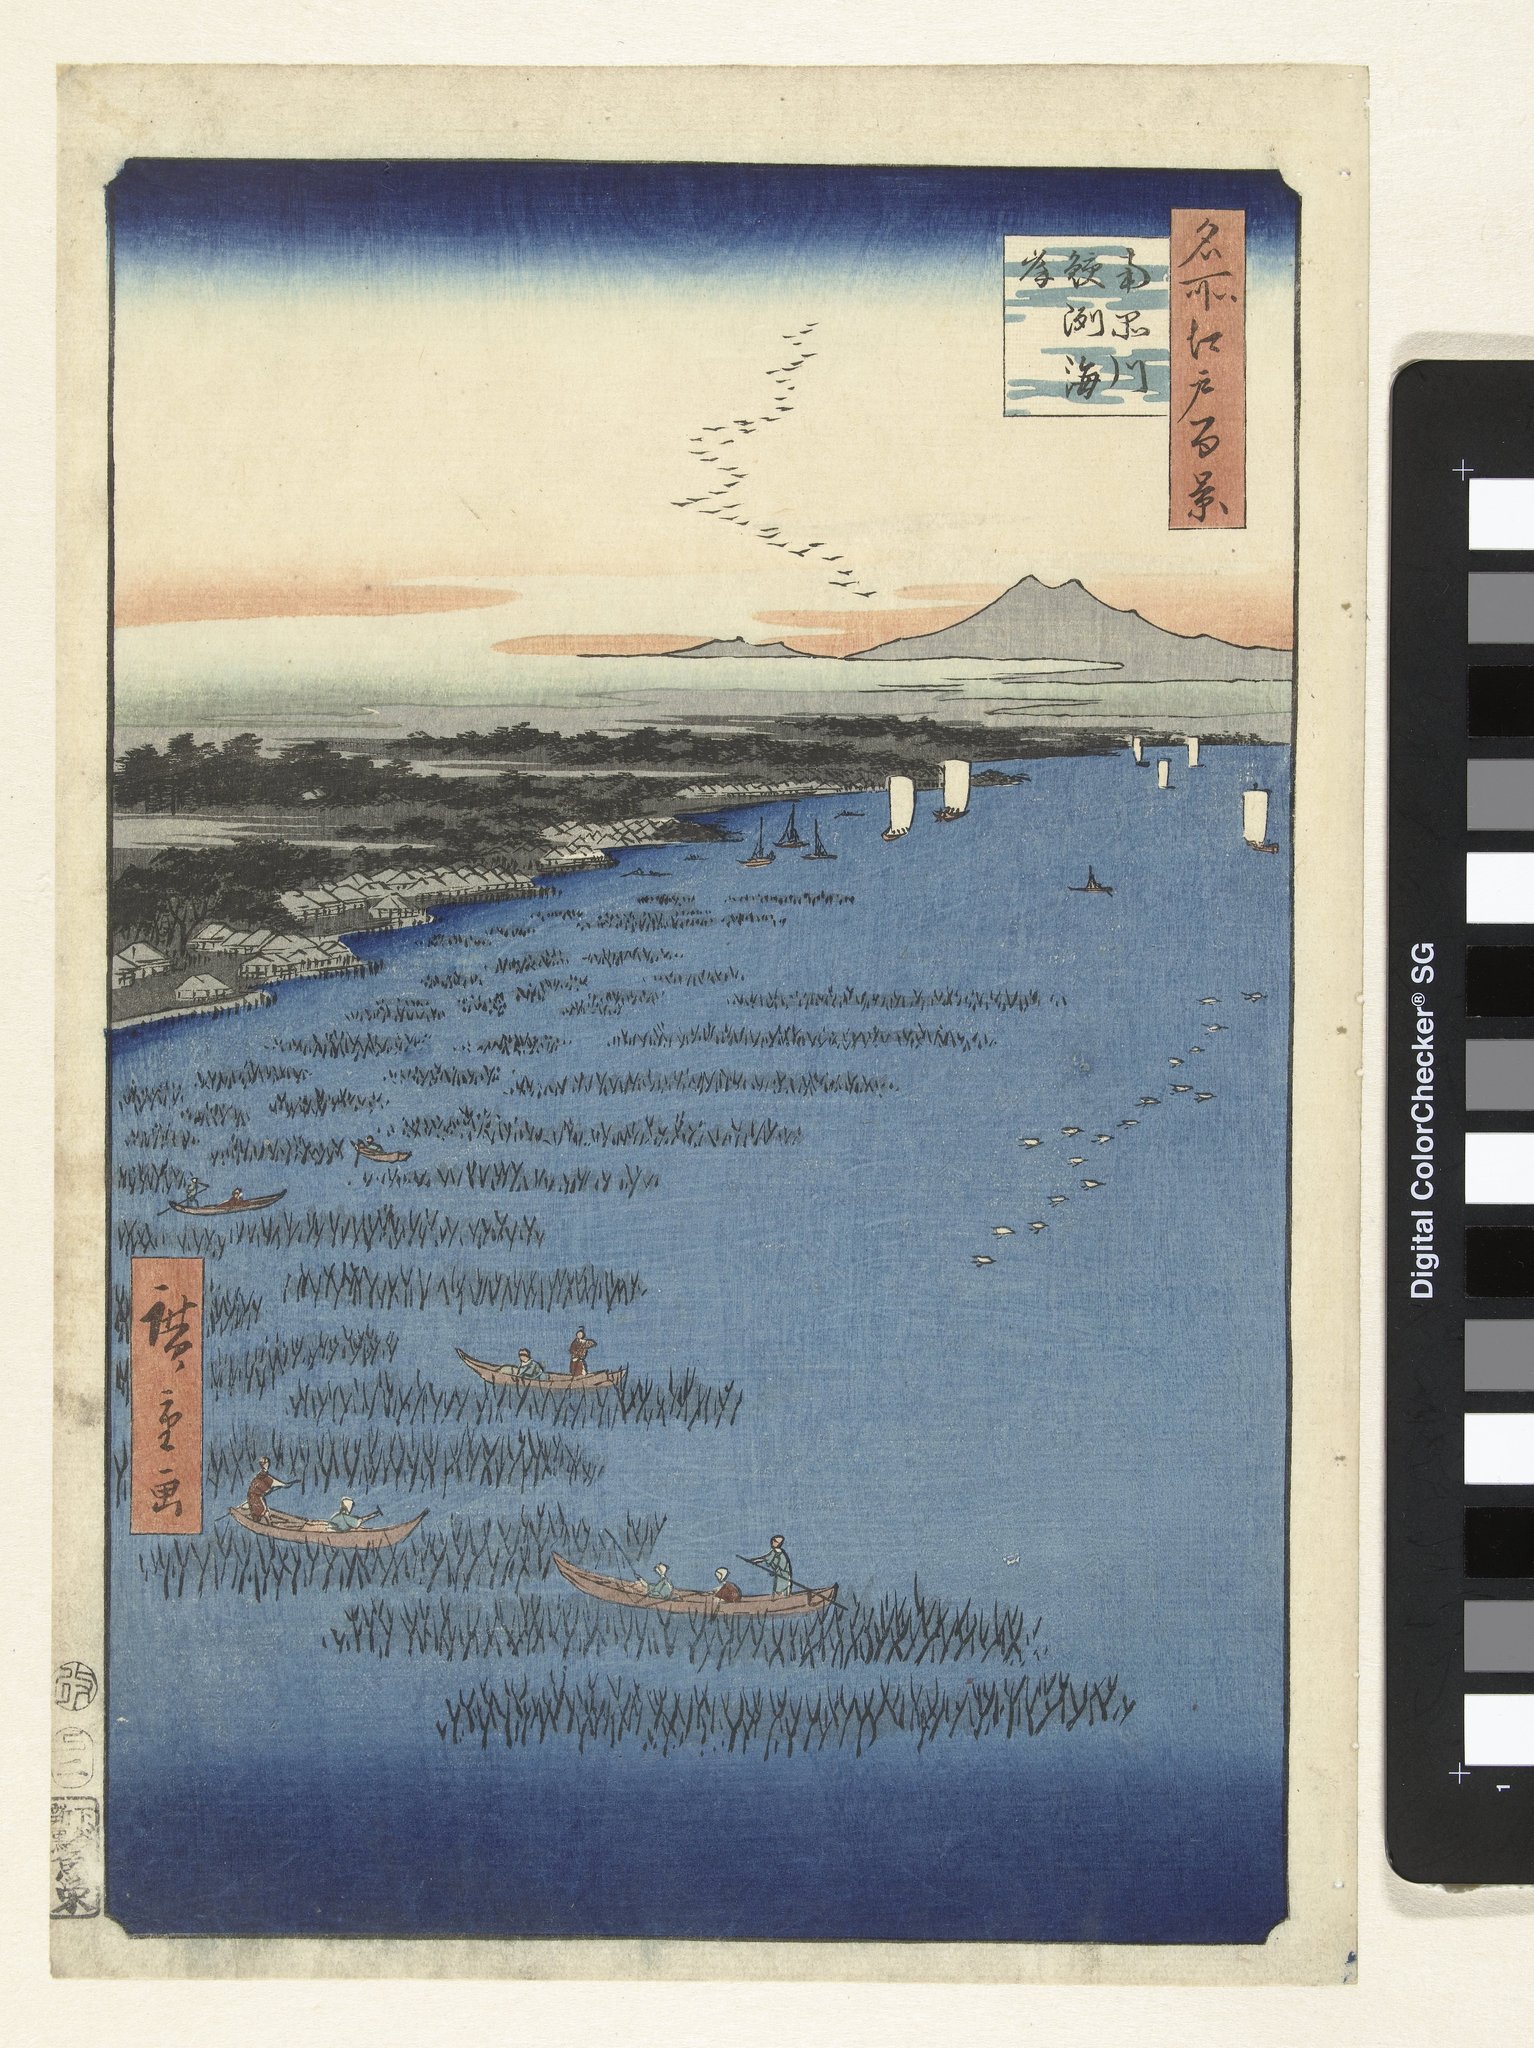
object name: print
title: Meisho Edo hyakkei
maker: utagawa hiroshige (i)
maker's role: draughtsman, print maker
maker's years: 1797-1858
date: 1802-1857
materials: paper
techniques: woodcut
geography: japan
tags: rowing-boat, canoe, etc., sea (seascape)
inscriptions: date